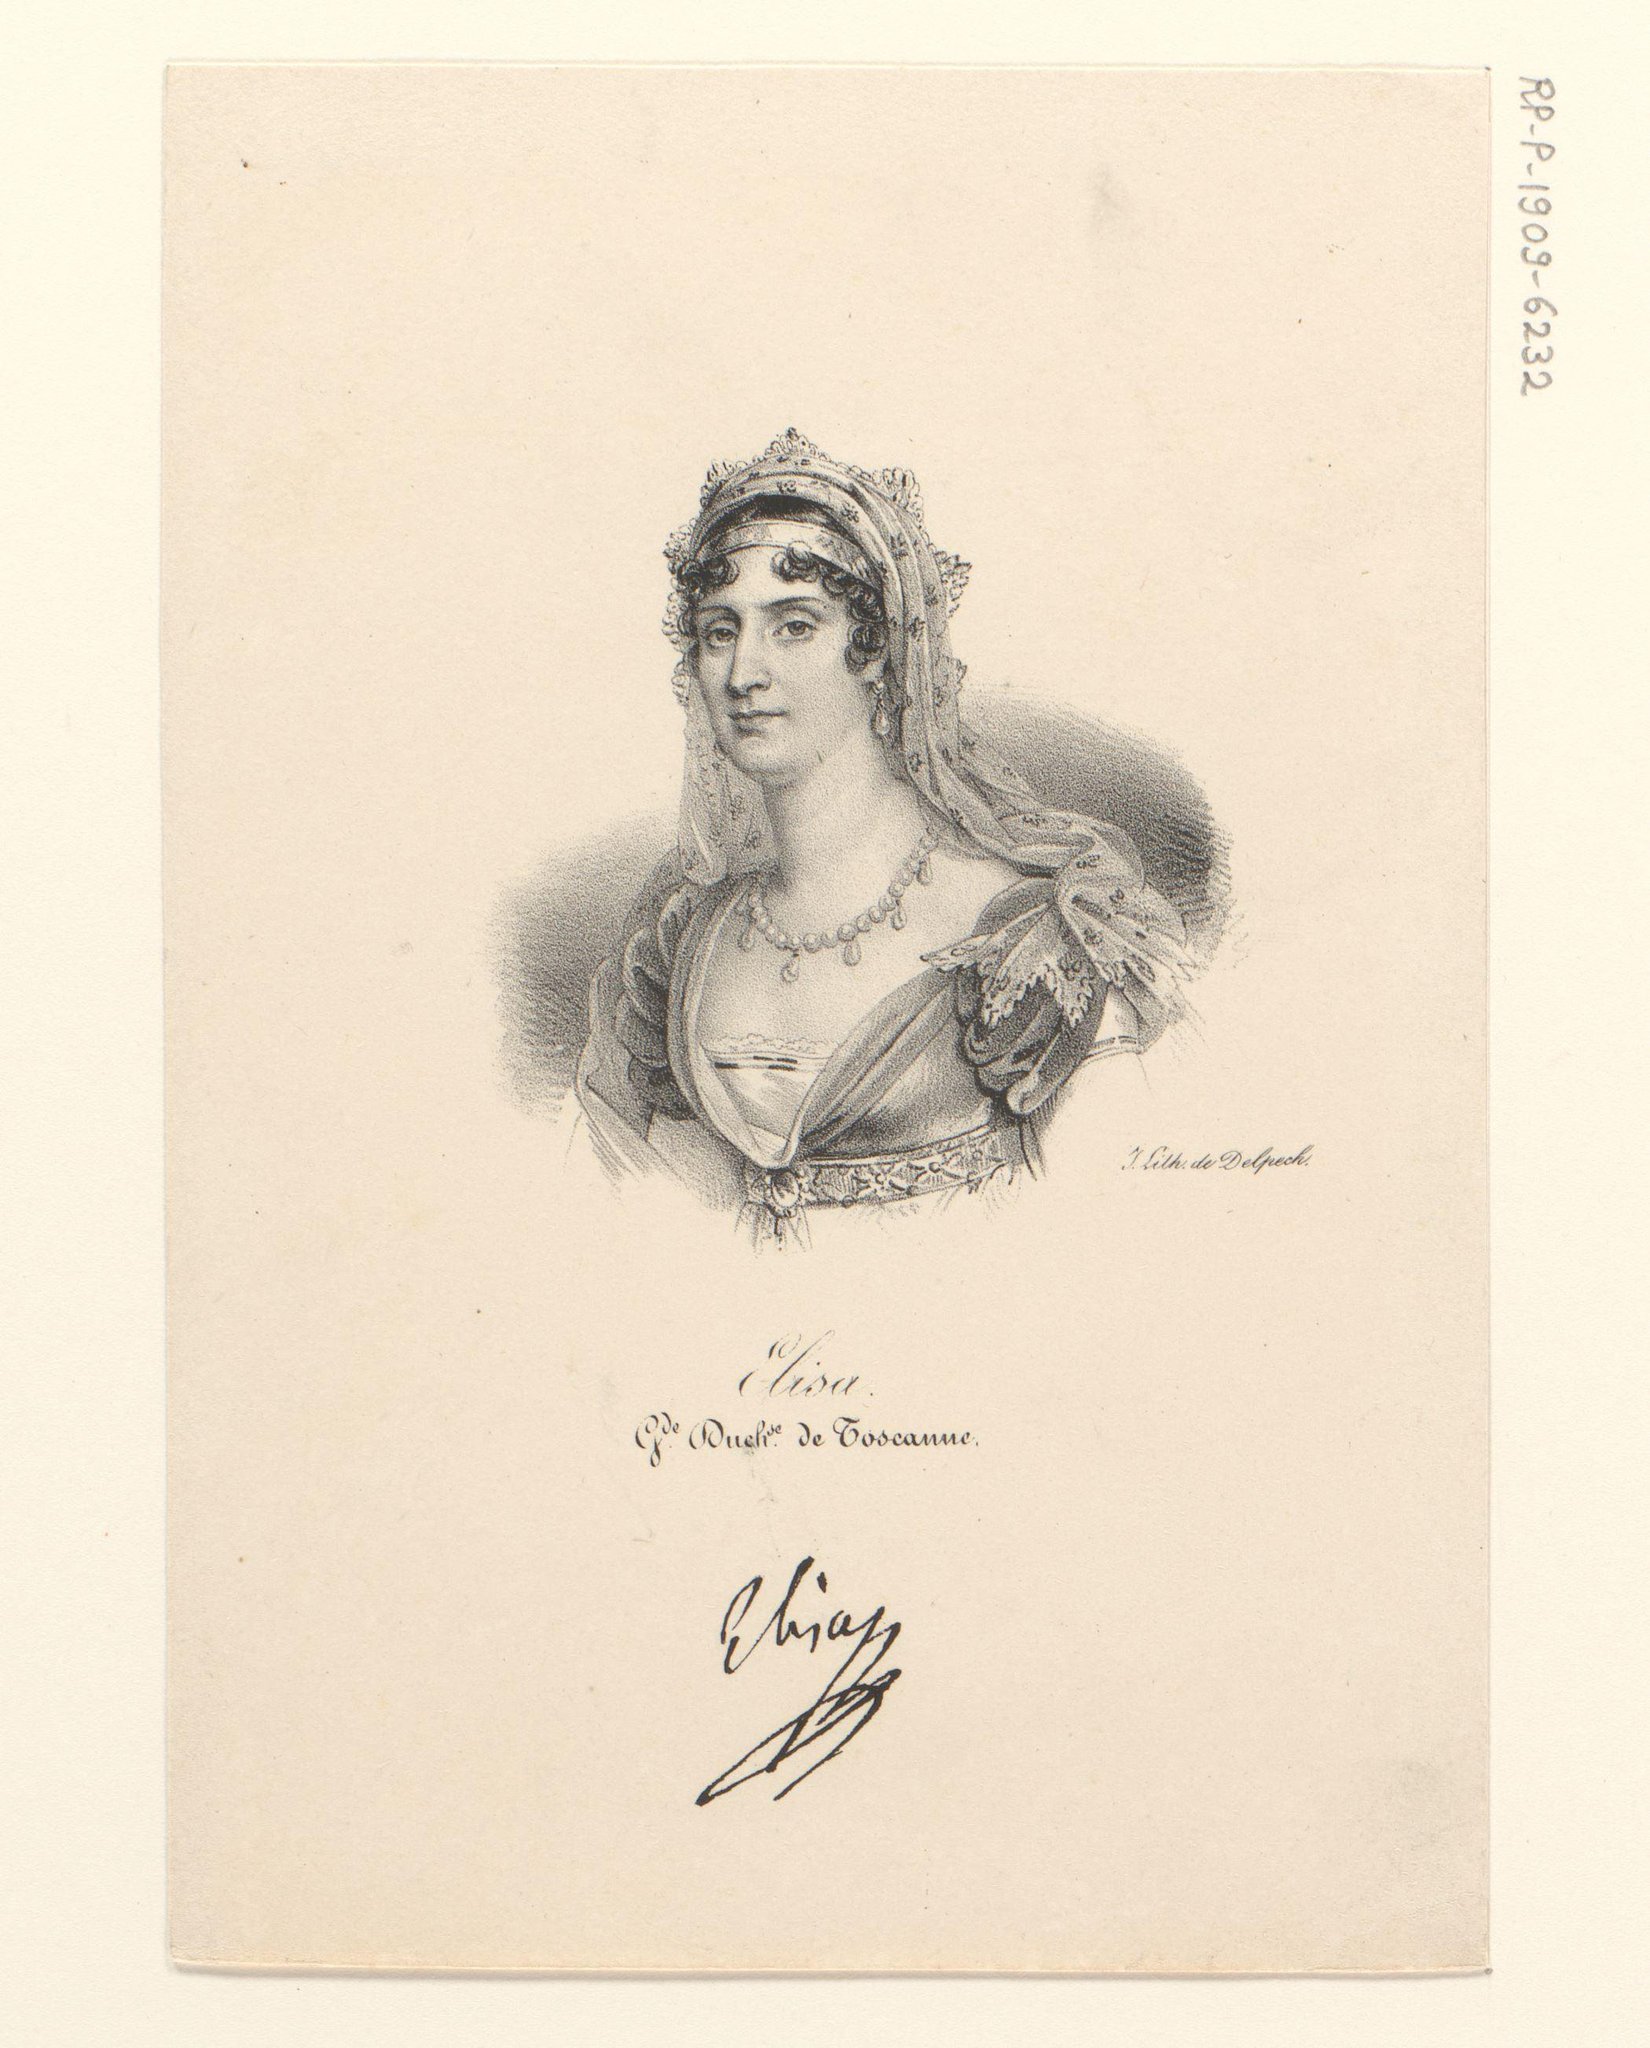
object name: print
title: Elisa, G.de Duch.se de Toscanne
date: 1818-1842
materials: paper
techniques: lithograph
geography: paris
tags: historical persons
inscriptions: collector's mark: Lugt 2228a